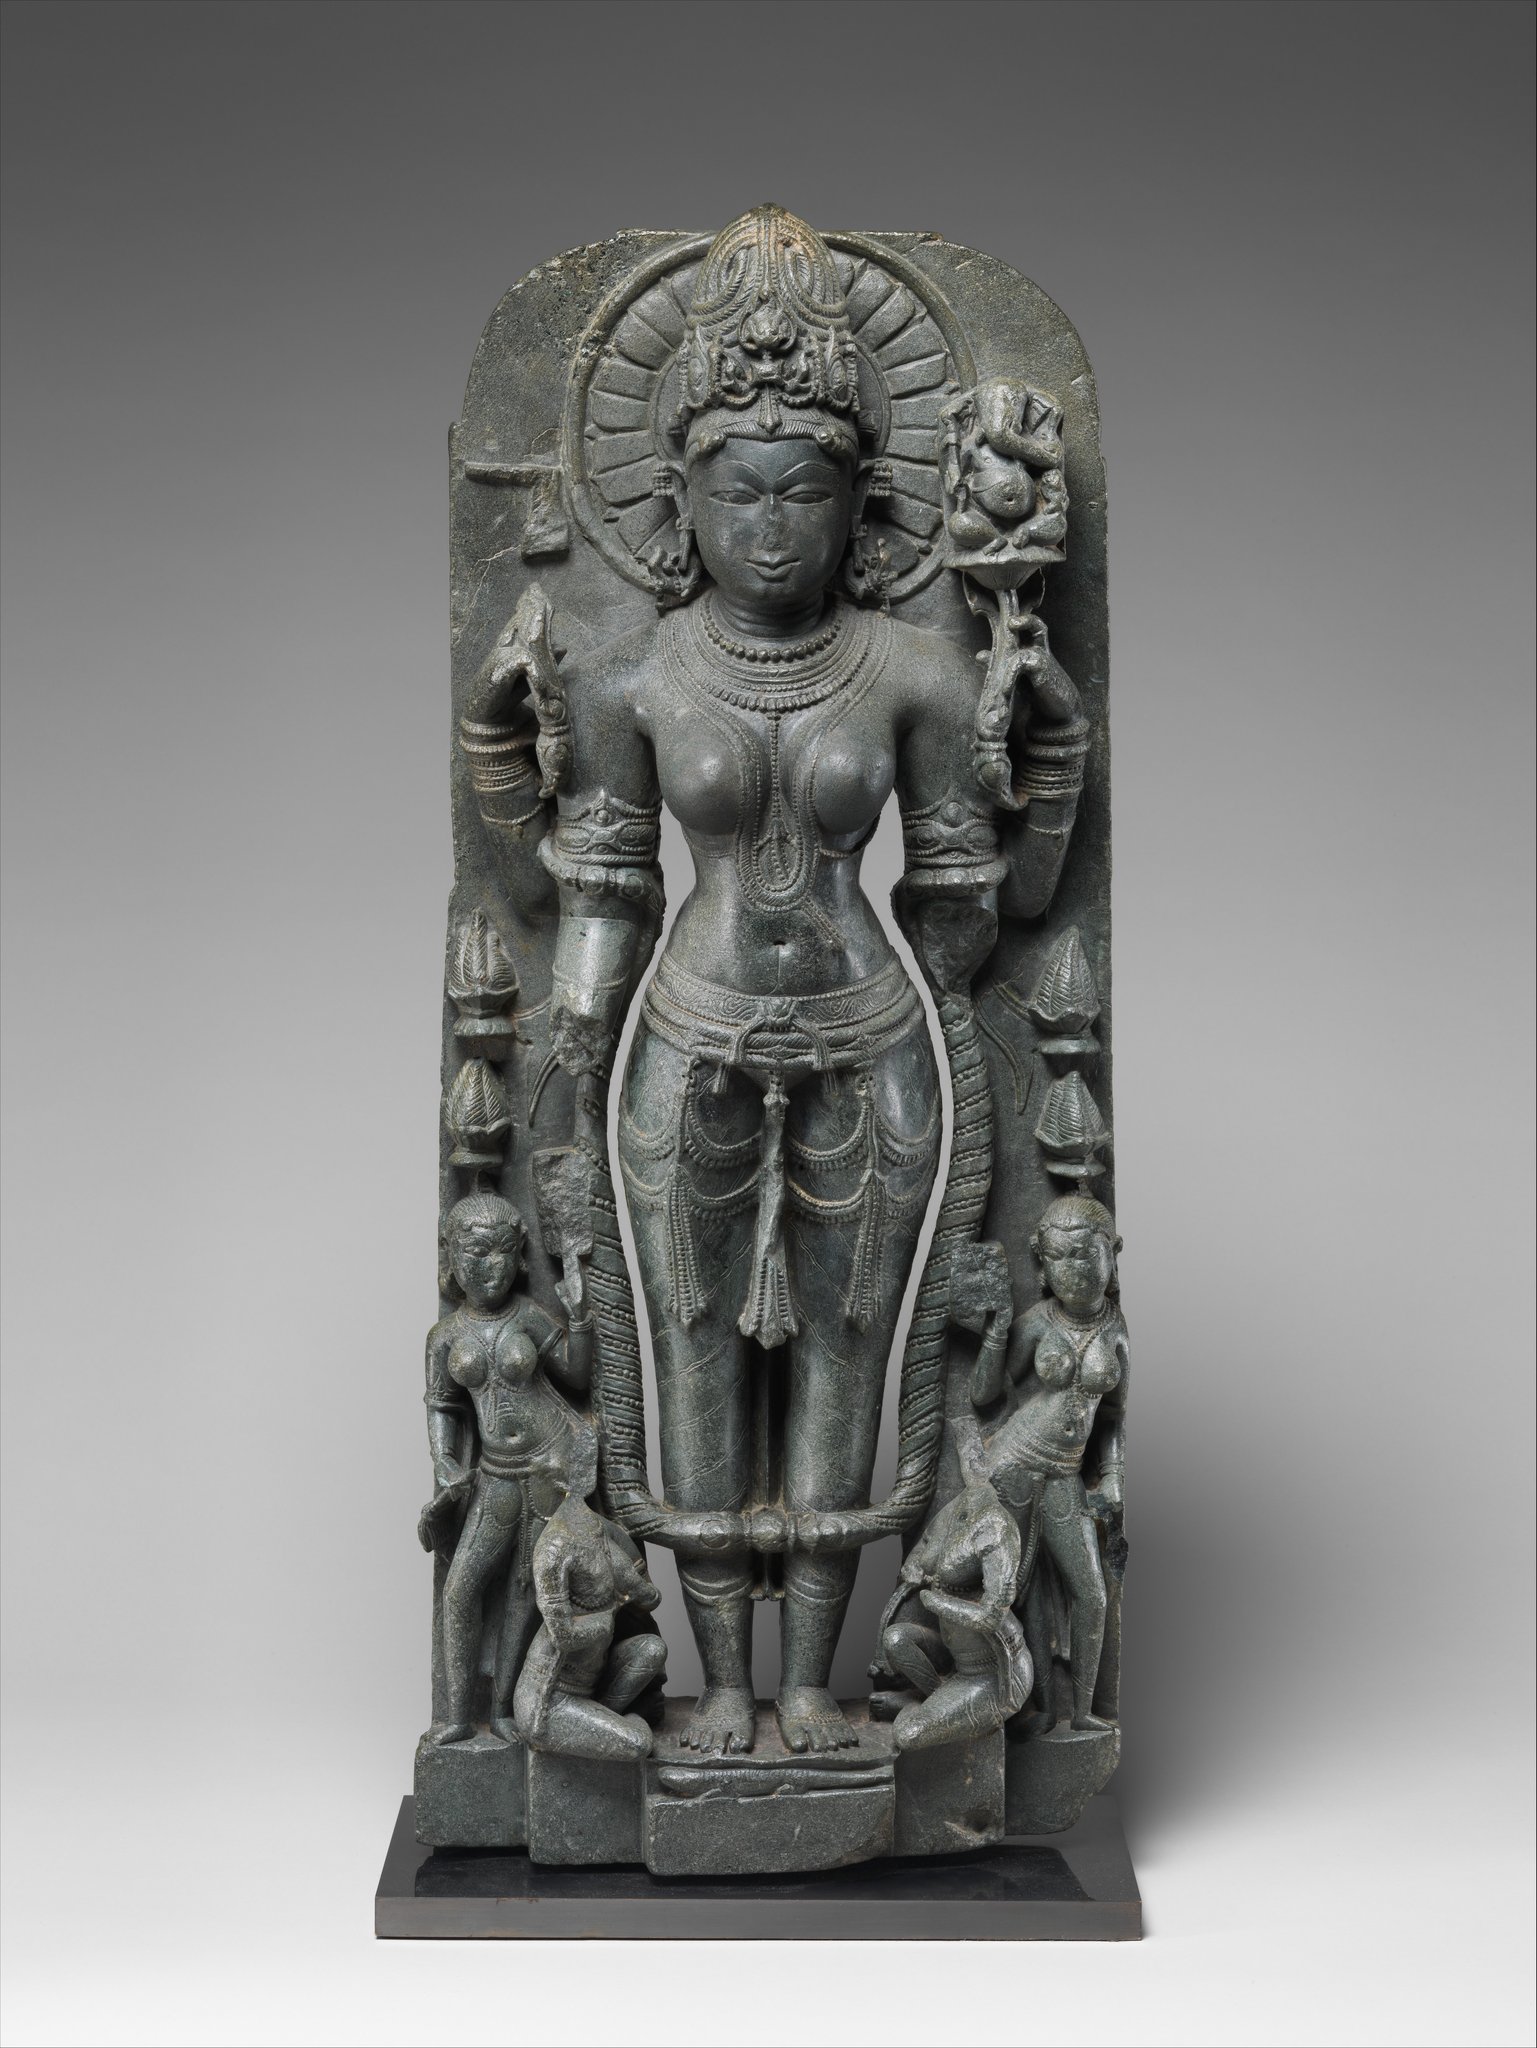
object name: stele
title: Goddess Gauri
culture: indian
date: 901-1000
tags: goddess